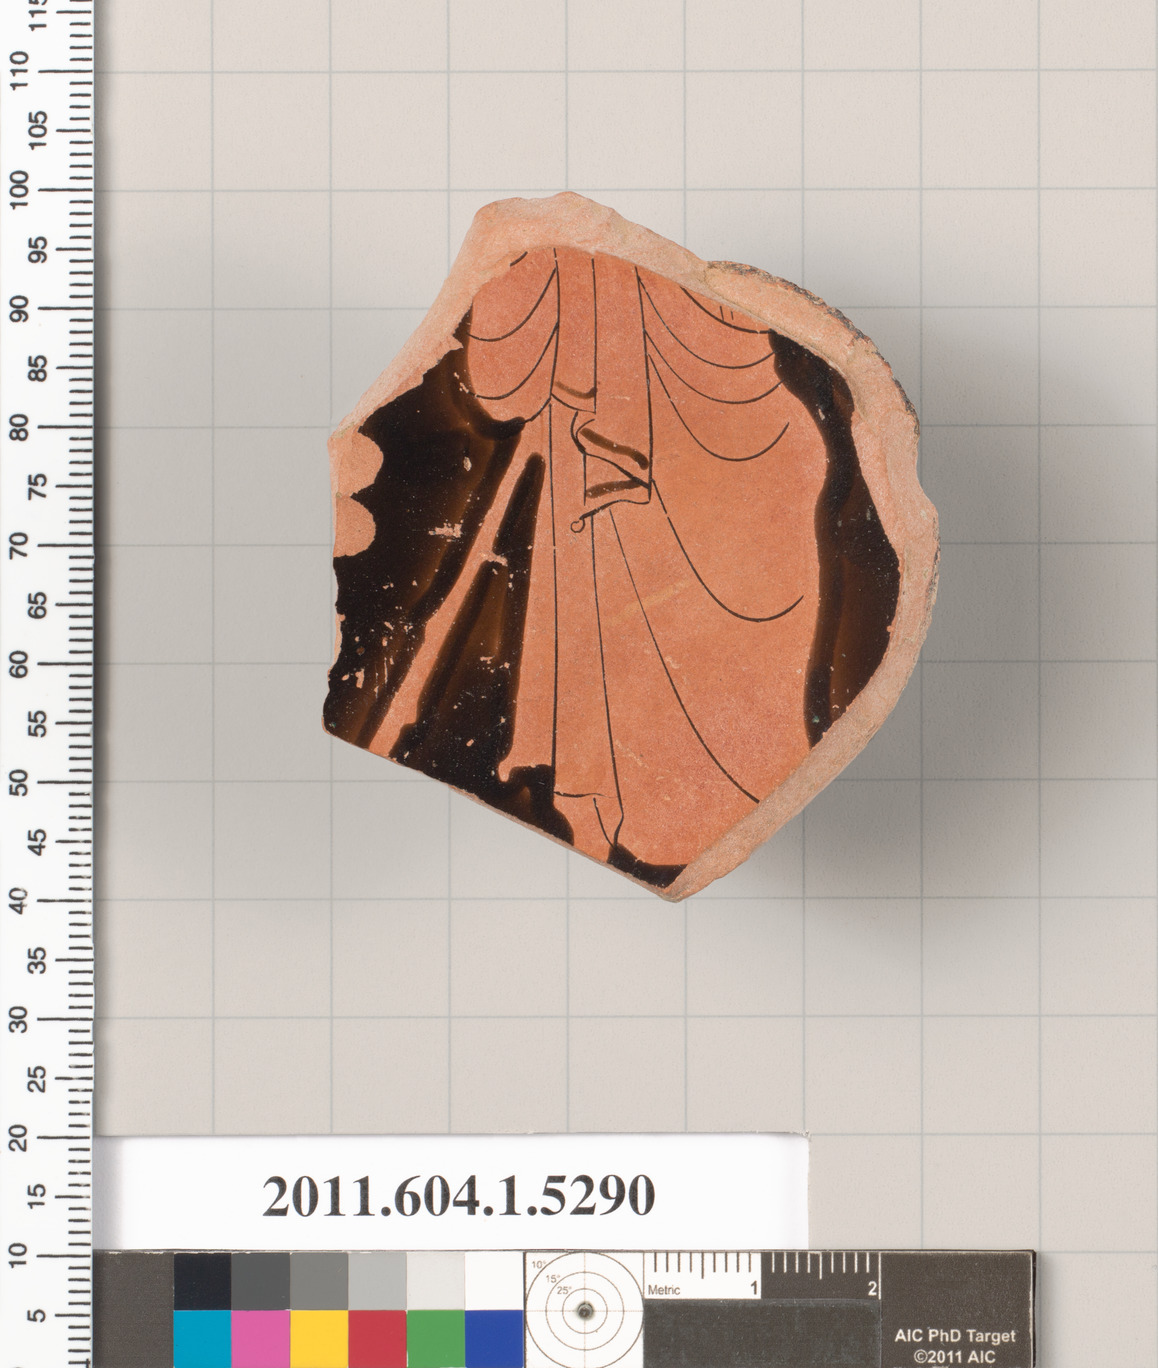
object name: kylix fragment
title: Terracotta fragment of a kylix (drinking cup)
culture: greek, attic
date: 475-451 BCE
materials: terracotta